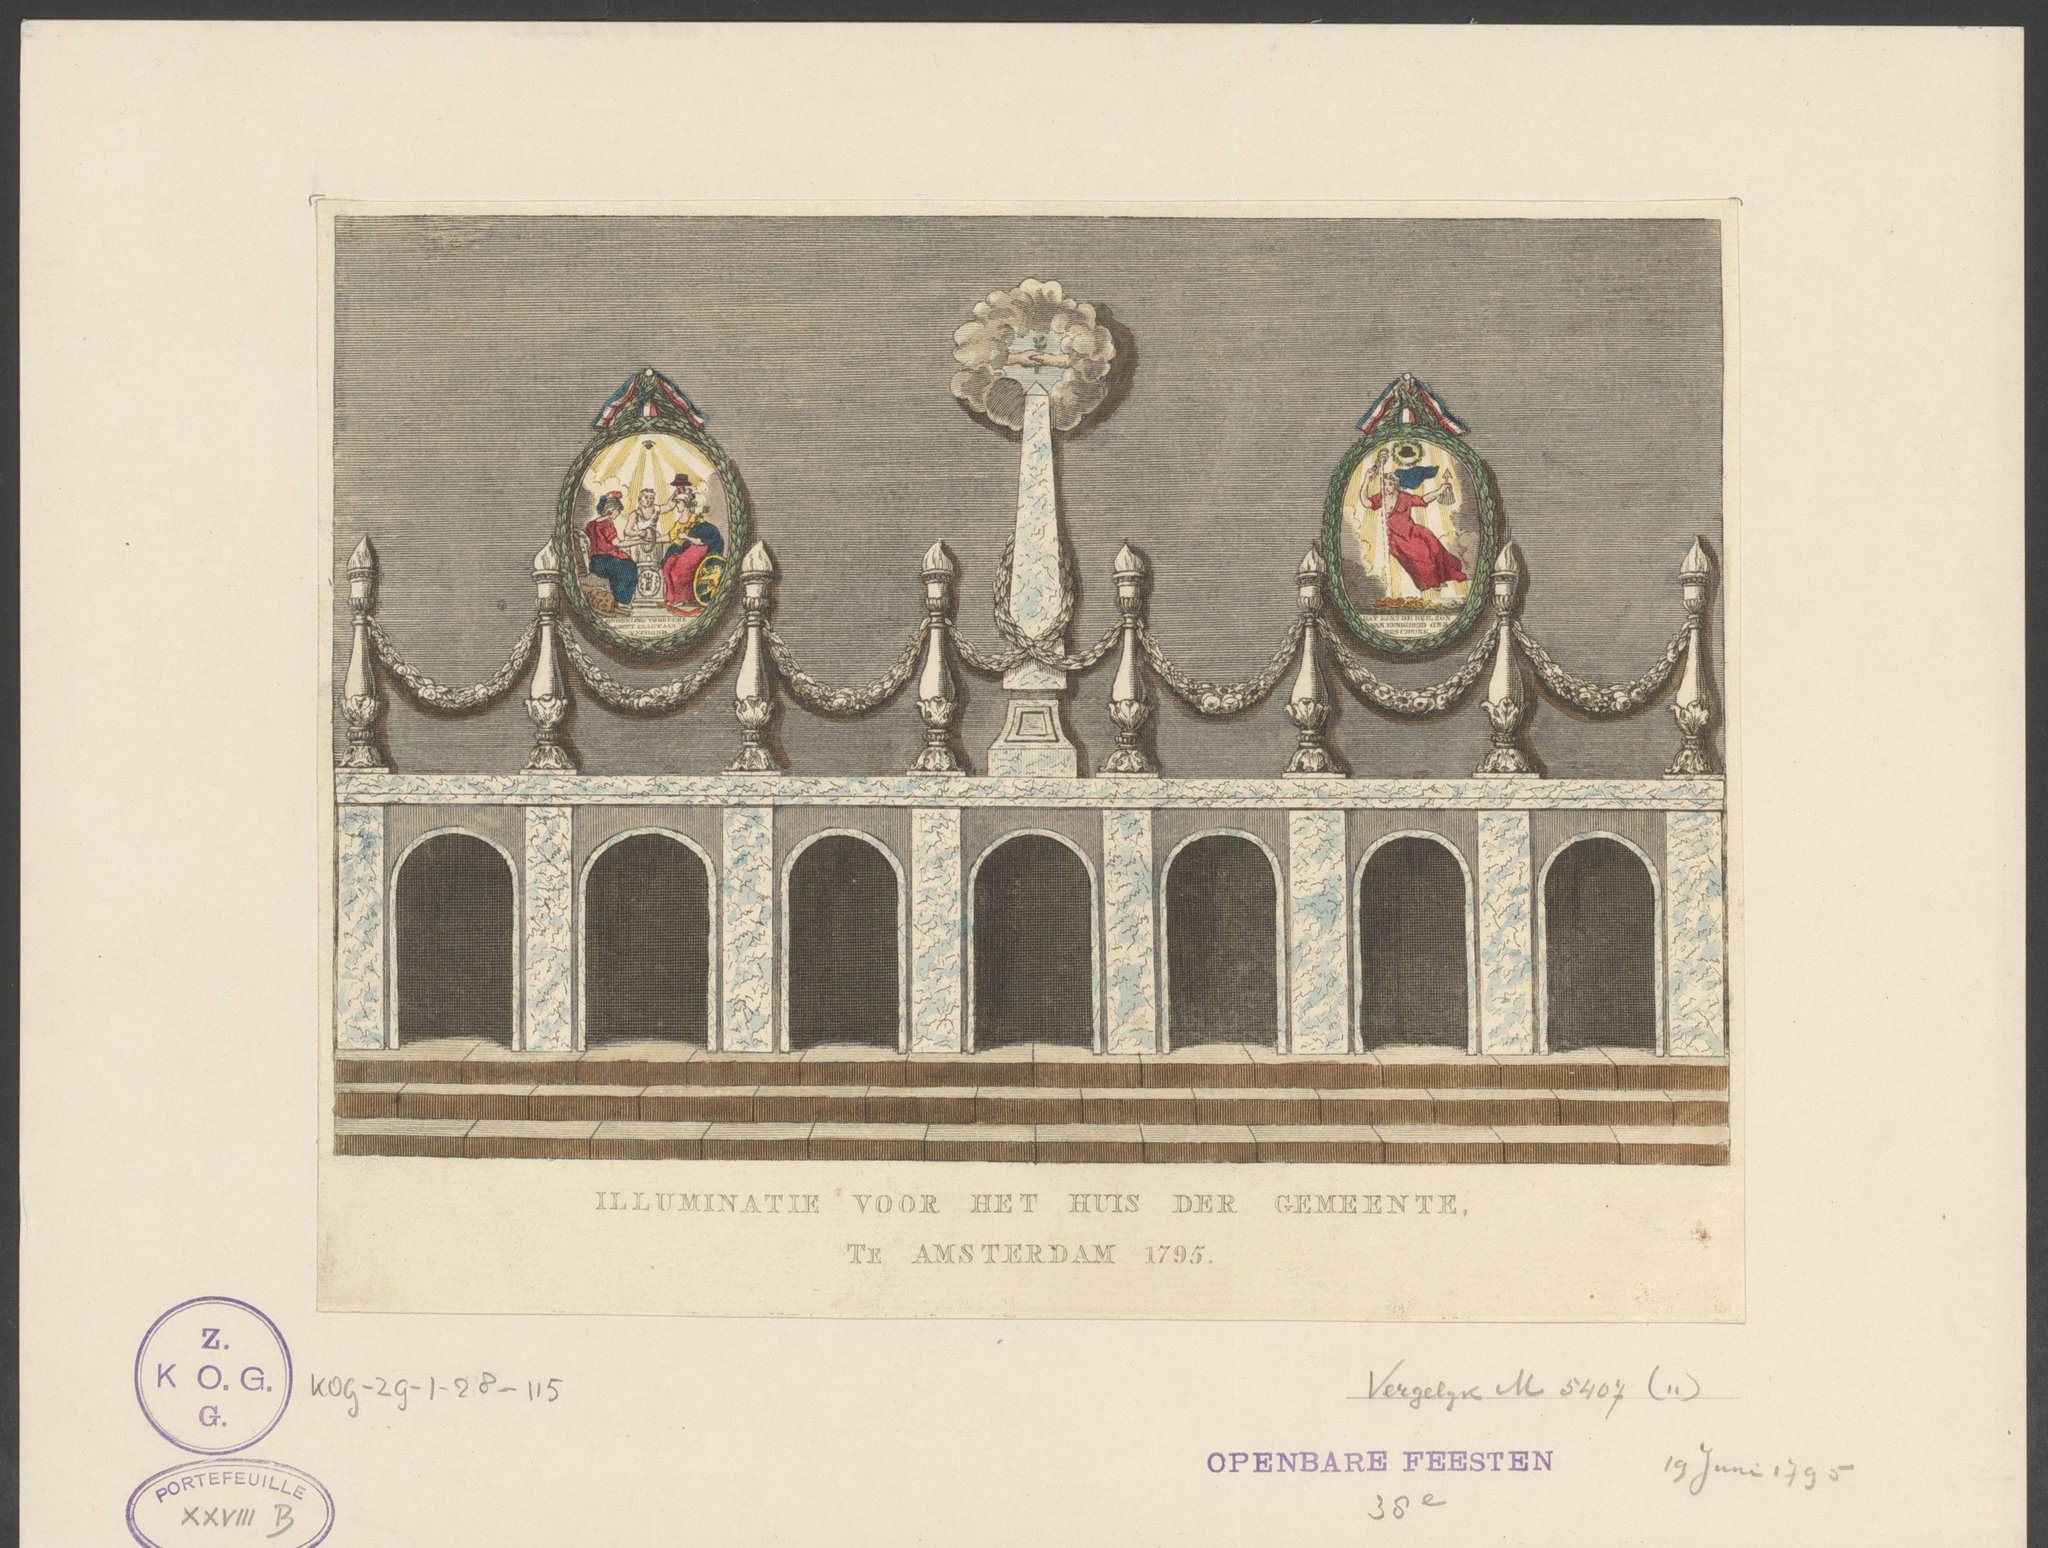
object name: print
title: Aanstaande Eenheid en Onverdeelbaarheid, van het Bataafse Gemenebest en de Alliantie, decoratie op het Stadhuis op de Dam, 1795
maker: a. schol (ii)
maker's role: print maker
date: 1795-1797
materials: paper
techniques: etching, hand coloring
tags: festivities on events of national importance (+ illumination, fire-works ~ festive activities), alliance with france (1795)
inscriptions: collector's mark: Lugt 1641, stamp, stamp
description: De Alliantie gesloten tussen de Franse en de Bataafse Republiek op 16 mei 1795 en de Aanstaande Eenheid en Onverdeelbaarheid van het Bataafse Gemenebest. Twee allegorische decoraties op de gevel van het Stadhuis op de Dam te Amsterdam bij het Alliantiefeest op 19 juni 1795. Onderdeel van een serie van dertien platen. Onderwerpsrubrieken binnen de Atlas Zeden en Gewoonten: Zeden en Gewoonten in Engeren Zin. Volksleven. Openbare feesten. Vorstelijke intochten, (Illuminaties, vuurwerken en dergelijke, openbare feesten).